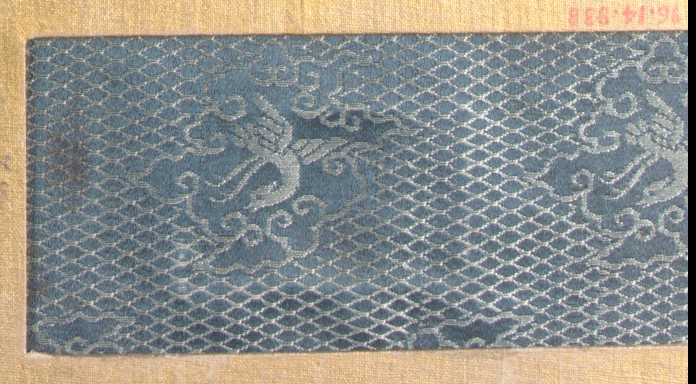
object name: piece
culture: japanese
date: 1701-1900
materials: silk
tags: birds